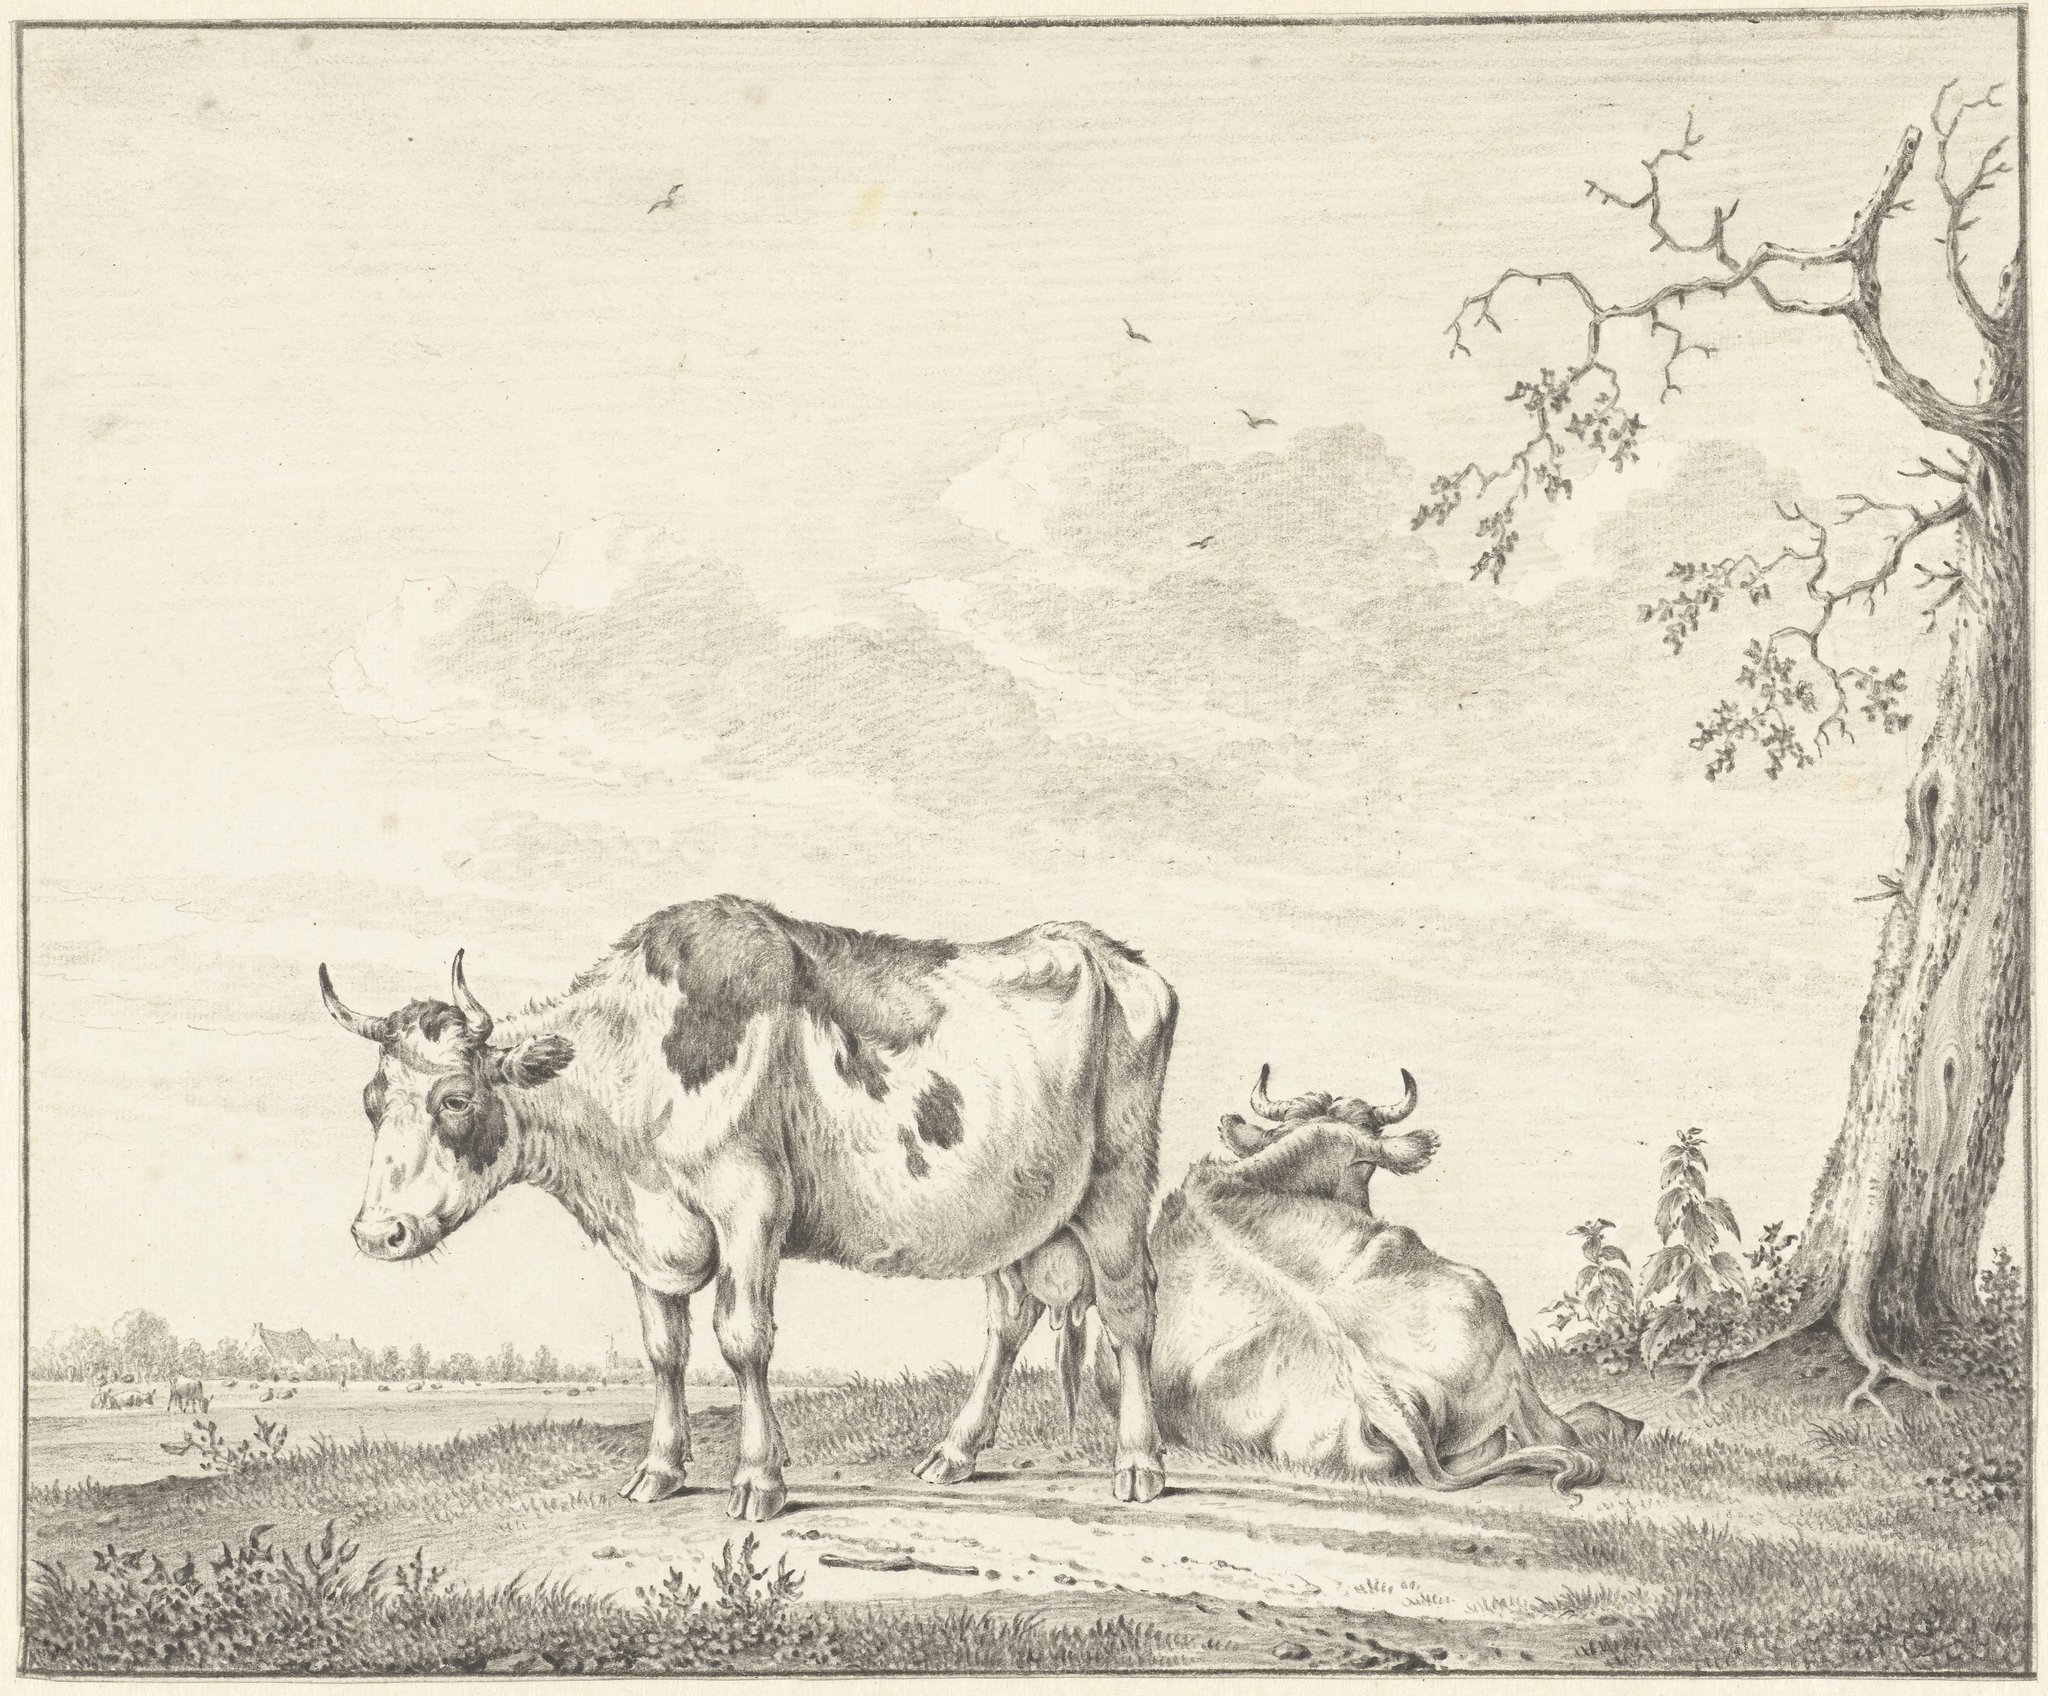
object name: drawing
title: Twee koeien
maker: pieter janson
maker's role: draughtsman, print maker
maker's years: 1765-1851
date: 1775-1851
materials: chalk, paper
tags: cow